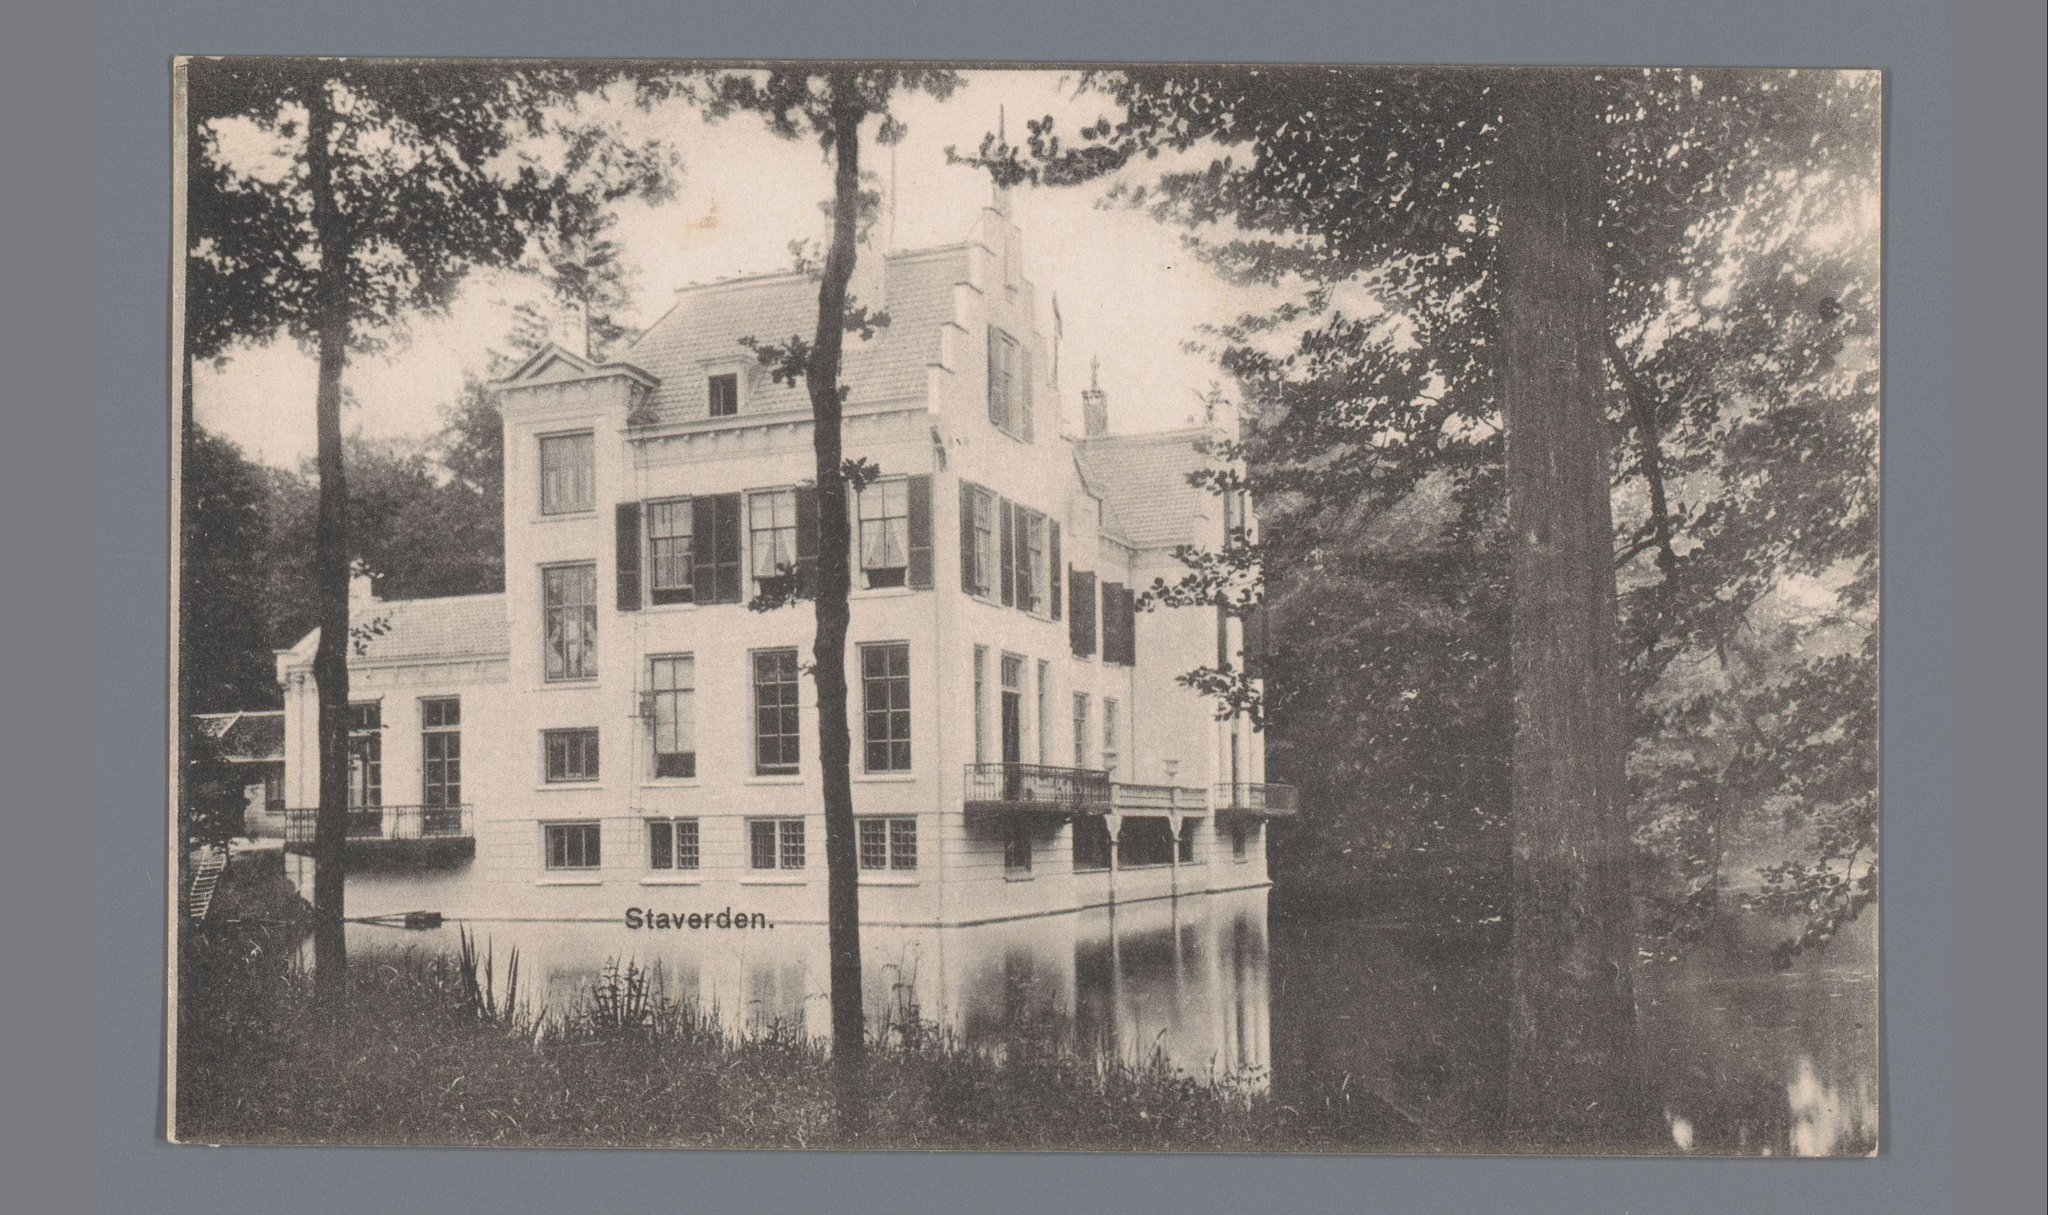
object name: photomechanical print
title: Landhuis Staverden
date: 1880-1907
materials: paper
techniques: photograph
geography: staverden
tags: rural housing, e.g. country-house, villa, cottage, façade (of house or building)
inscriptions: inscription: ‘Nederland 1 cent’, stamp: ‘Lage-vuursche 17 aug 07’, workshop stamp: ‘Phot. v. M.C. Termaat, Nijmegen. Nadruk verboden.’, annotation: ‘Mademoiselles van der Waals/ Ewijkshoeve, Lage Vuursche [...]’